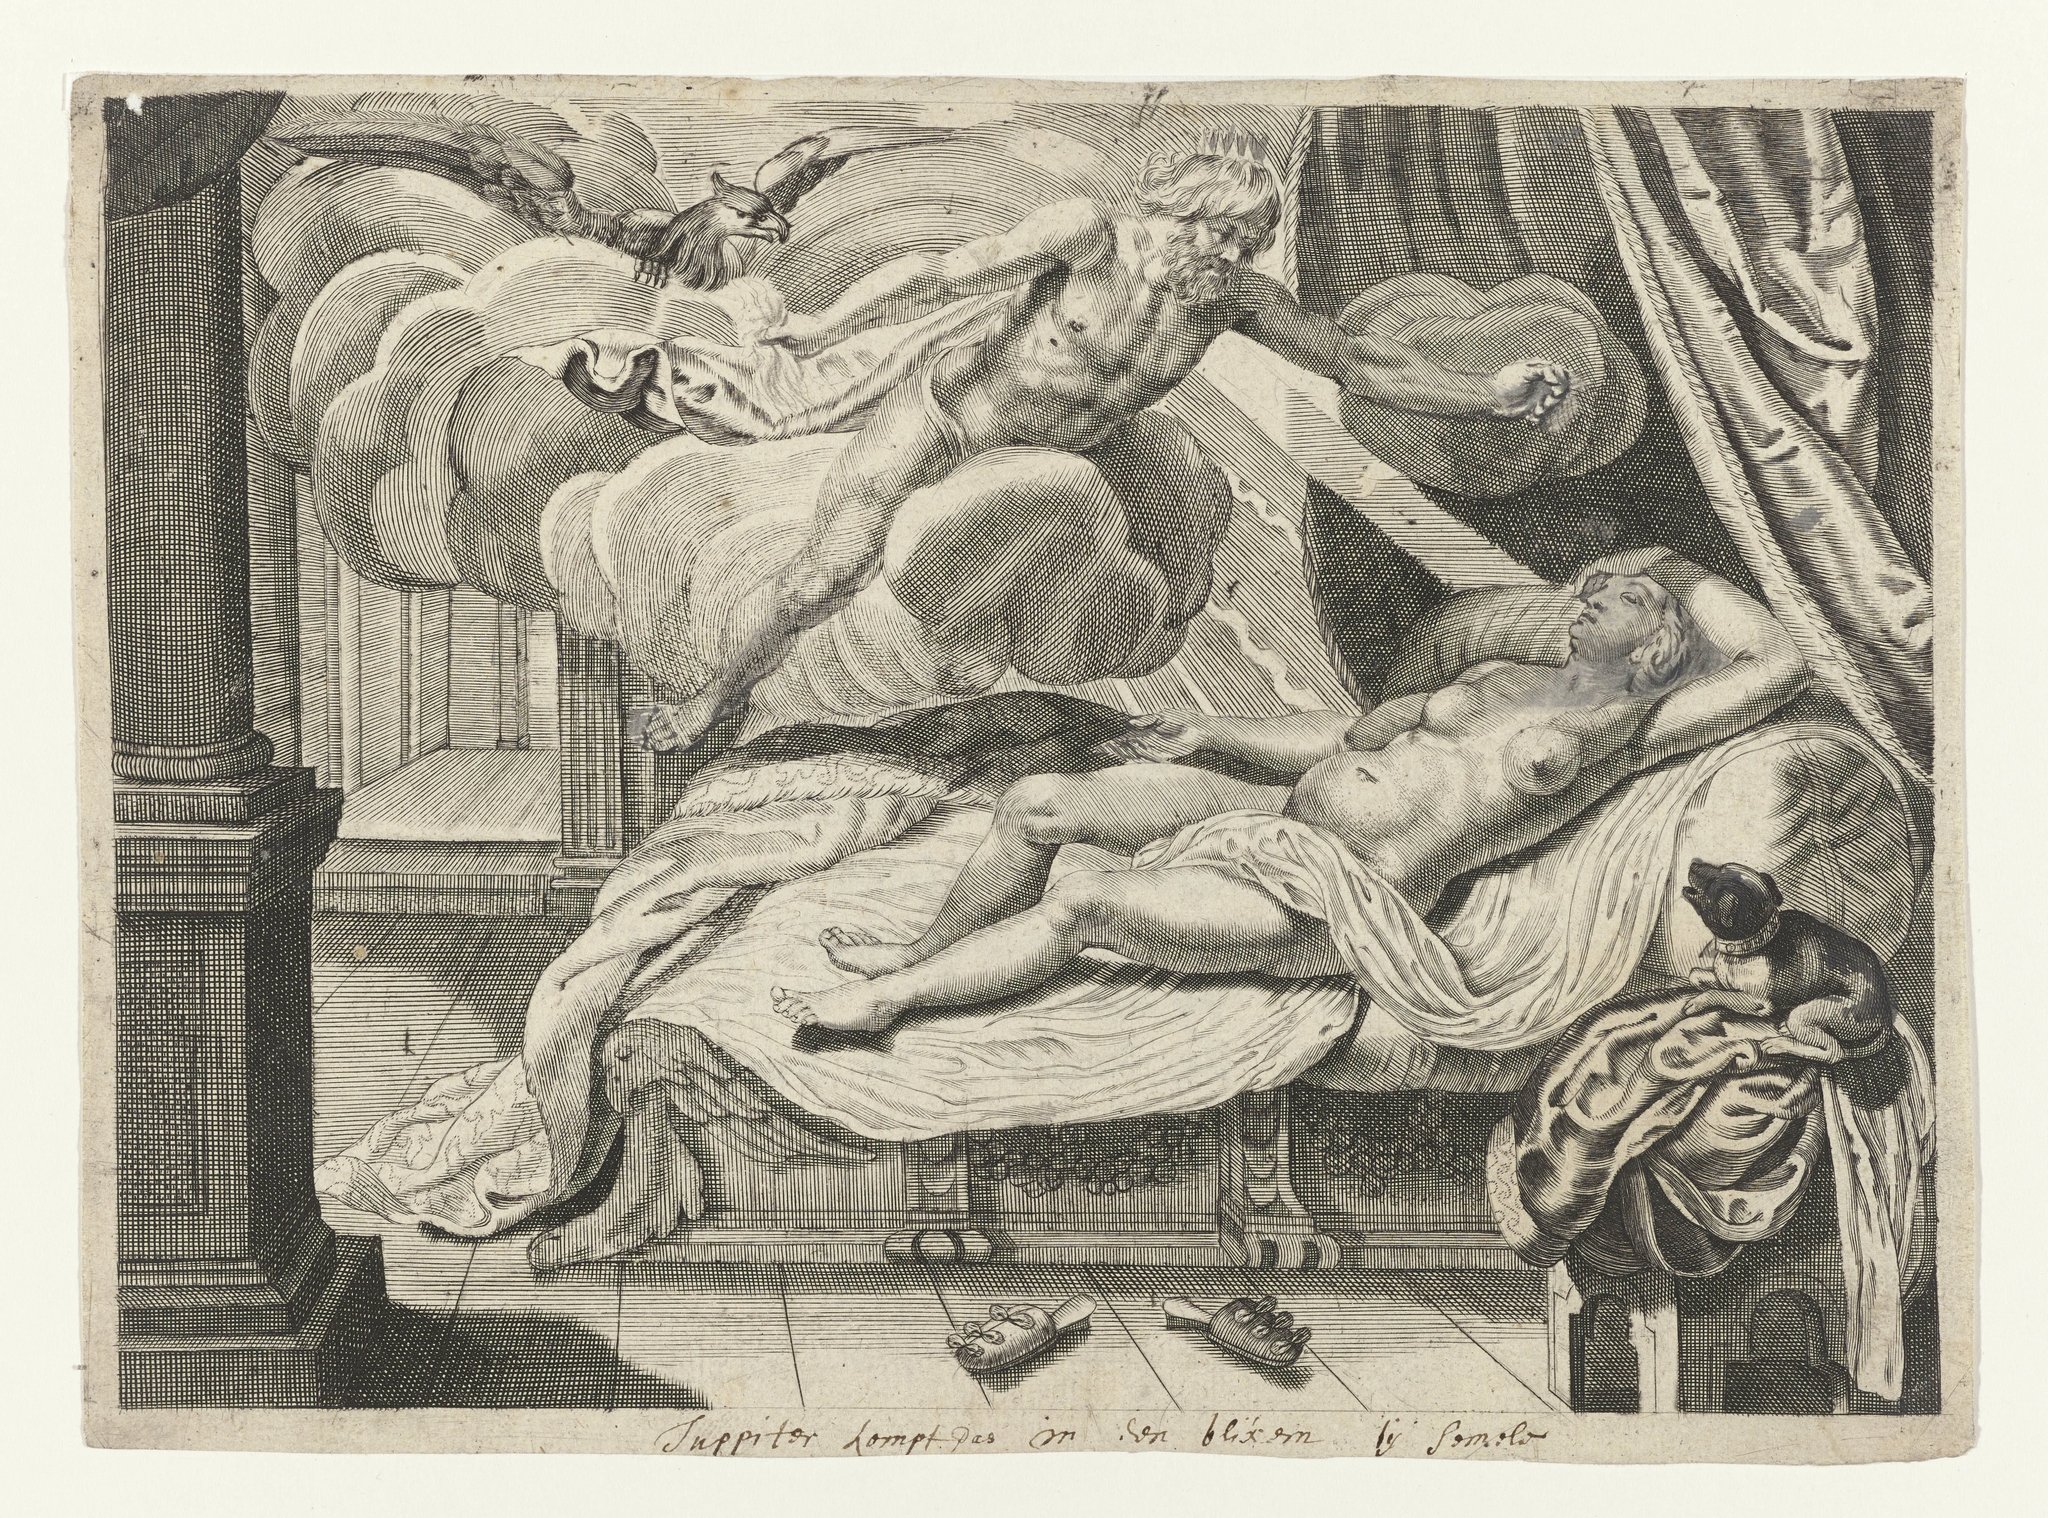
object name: print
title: Metamorfosen van Ovidius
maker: crispijn van de passe (ii)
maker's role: draughtsman, print maker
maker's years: 1594-1670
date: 1636-1670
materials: paper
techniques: engraving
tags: jupiter kills semele by coming to her with his lightning and thunderbolts, bed with tester, attributes of jupiter: eagle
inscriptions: number: ‘30’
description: De ambitieuze reeks naar ontwerpen van ondermeer Jacob Pynas, Roeland Savery, Pieter Clouwet, Rubens en Rembrandt is nooit voltooid door de De Passes. De reeks werd uiteindelijk in 1677 in boekvorm uitgegeven in Brussel door Piere Du Rayer en Francois Foppes. Als losse prenten is de reeks alleen bekend uit een groep prenten afkomstig uit de collectie Hinloopen (1619-1708) die zich in het Rijksprentenkabinet bevindt. Deze groep is uitgebreid beschreven door Jan van der Waals in zijn Hinloopen-catalogus (zie: ''Een onbekende editie van een serie Ovidius-illustraties'' in De prentschat van Michiel Hinloopen, 1988, p. 79-102.). De ontdekking van een tweede groep afdrukken van de reeks, afkomstig uit de werkplaats van Crispijn de Passe de Jonge, biedt een belangrijke aanvulling op de Hinloopen-groep. Sommige afdrukken tonen de prenten in onvoltooide staat en zijn voorzien van verbeteringen en toevoegingen in pen en penseel. Bovendien zijn alle prenten voorzien van 17de-eeuwse opschriften die het in een aantal gevallen mogelijk maakt de ontwerpers van de voorstellingen nader te identificeren. Op grond van de aangetroffen watermerken kunnen de afdrukken worden gedateerd omstreeks 1652-1653.